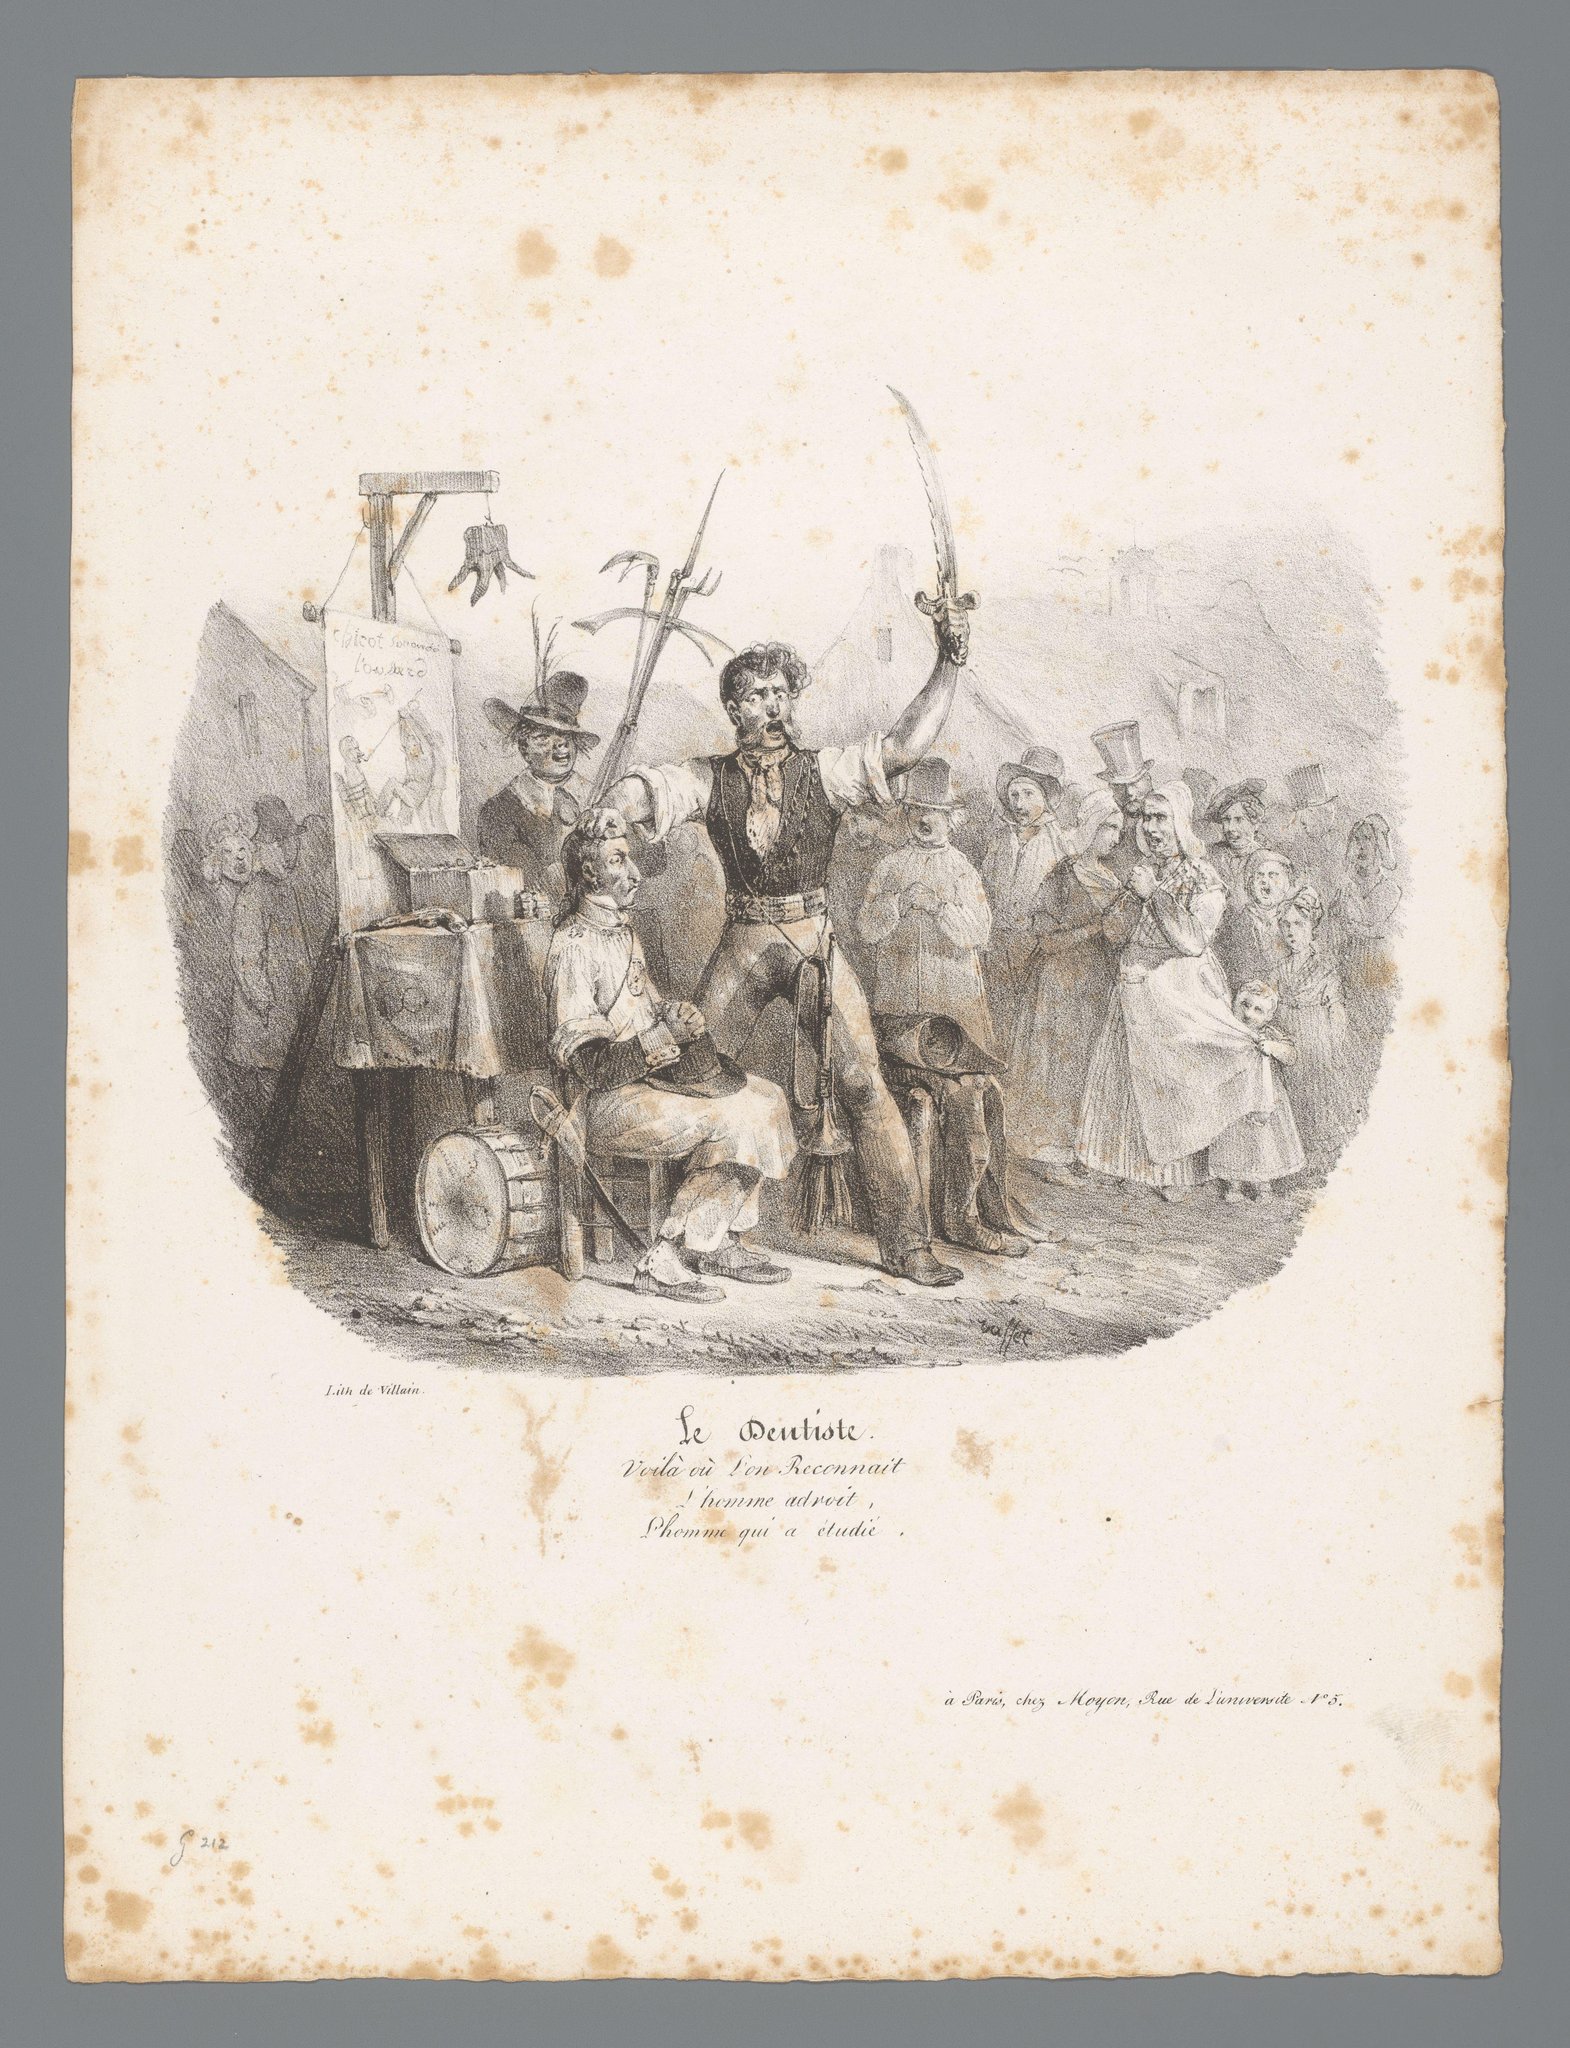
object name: print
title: Man op stoel met ernaast beul met zwaard en trompet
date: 1825-1829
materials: paper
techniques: lithograph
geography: paris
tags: instruments of torture, execution or punishment: gallows, hacking and thrusting weapons: sword, executioner, hangman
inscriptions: collector's mark: Lugt 964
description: Man op stoel is een landbewaarder, ernaast een beul met zwaard en trompet omringd door omstanders. Links een galg met kies aan een haak.